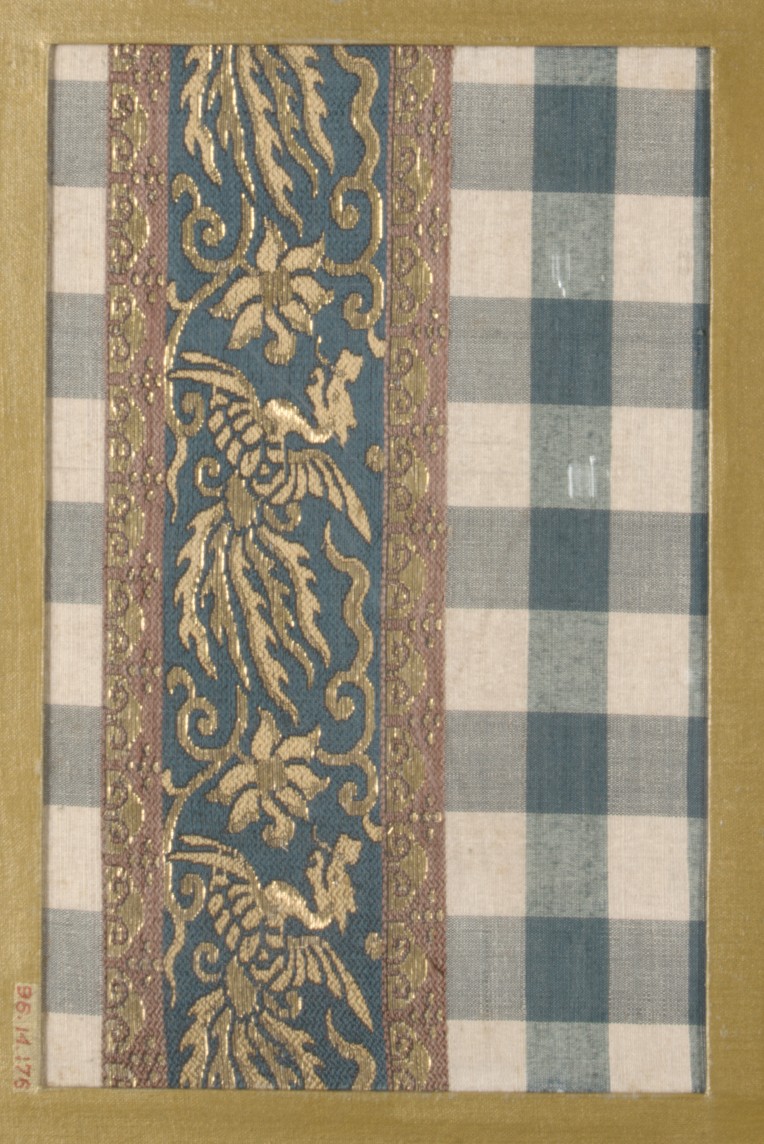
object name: fragment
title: Textile fragment with pattern of checks with band of phoenixes and flowers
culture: japanese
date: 1701-1900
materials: silk